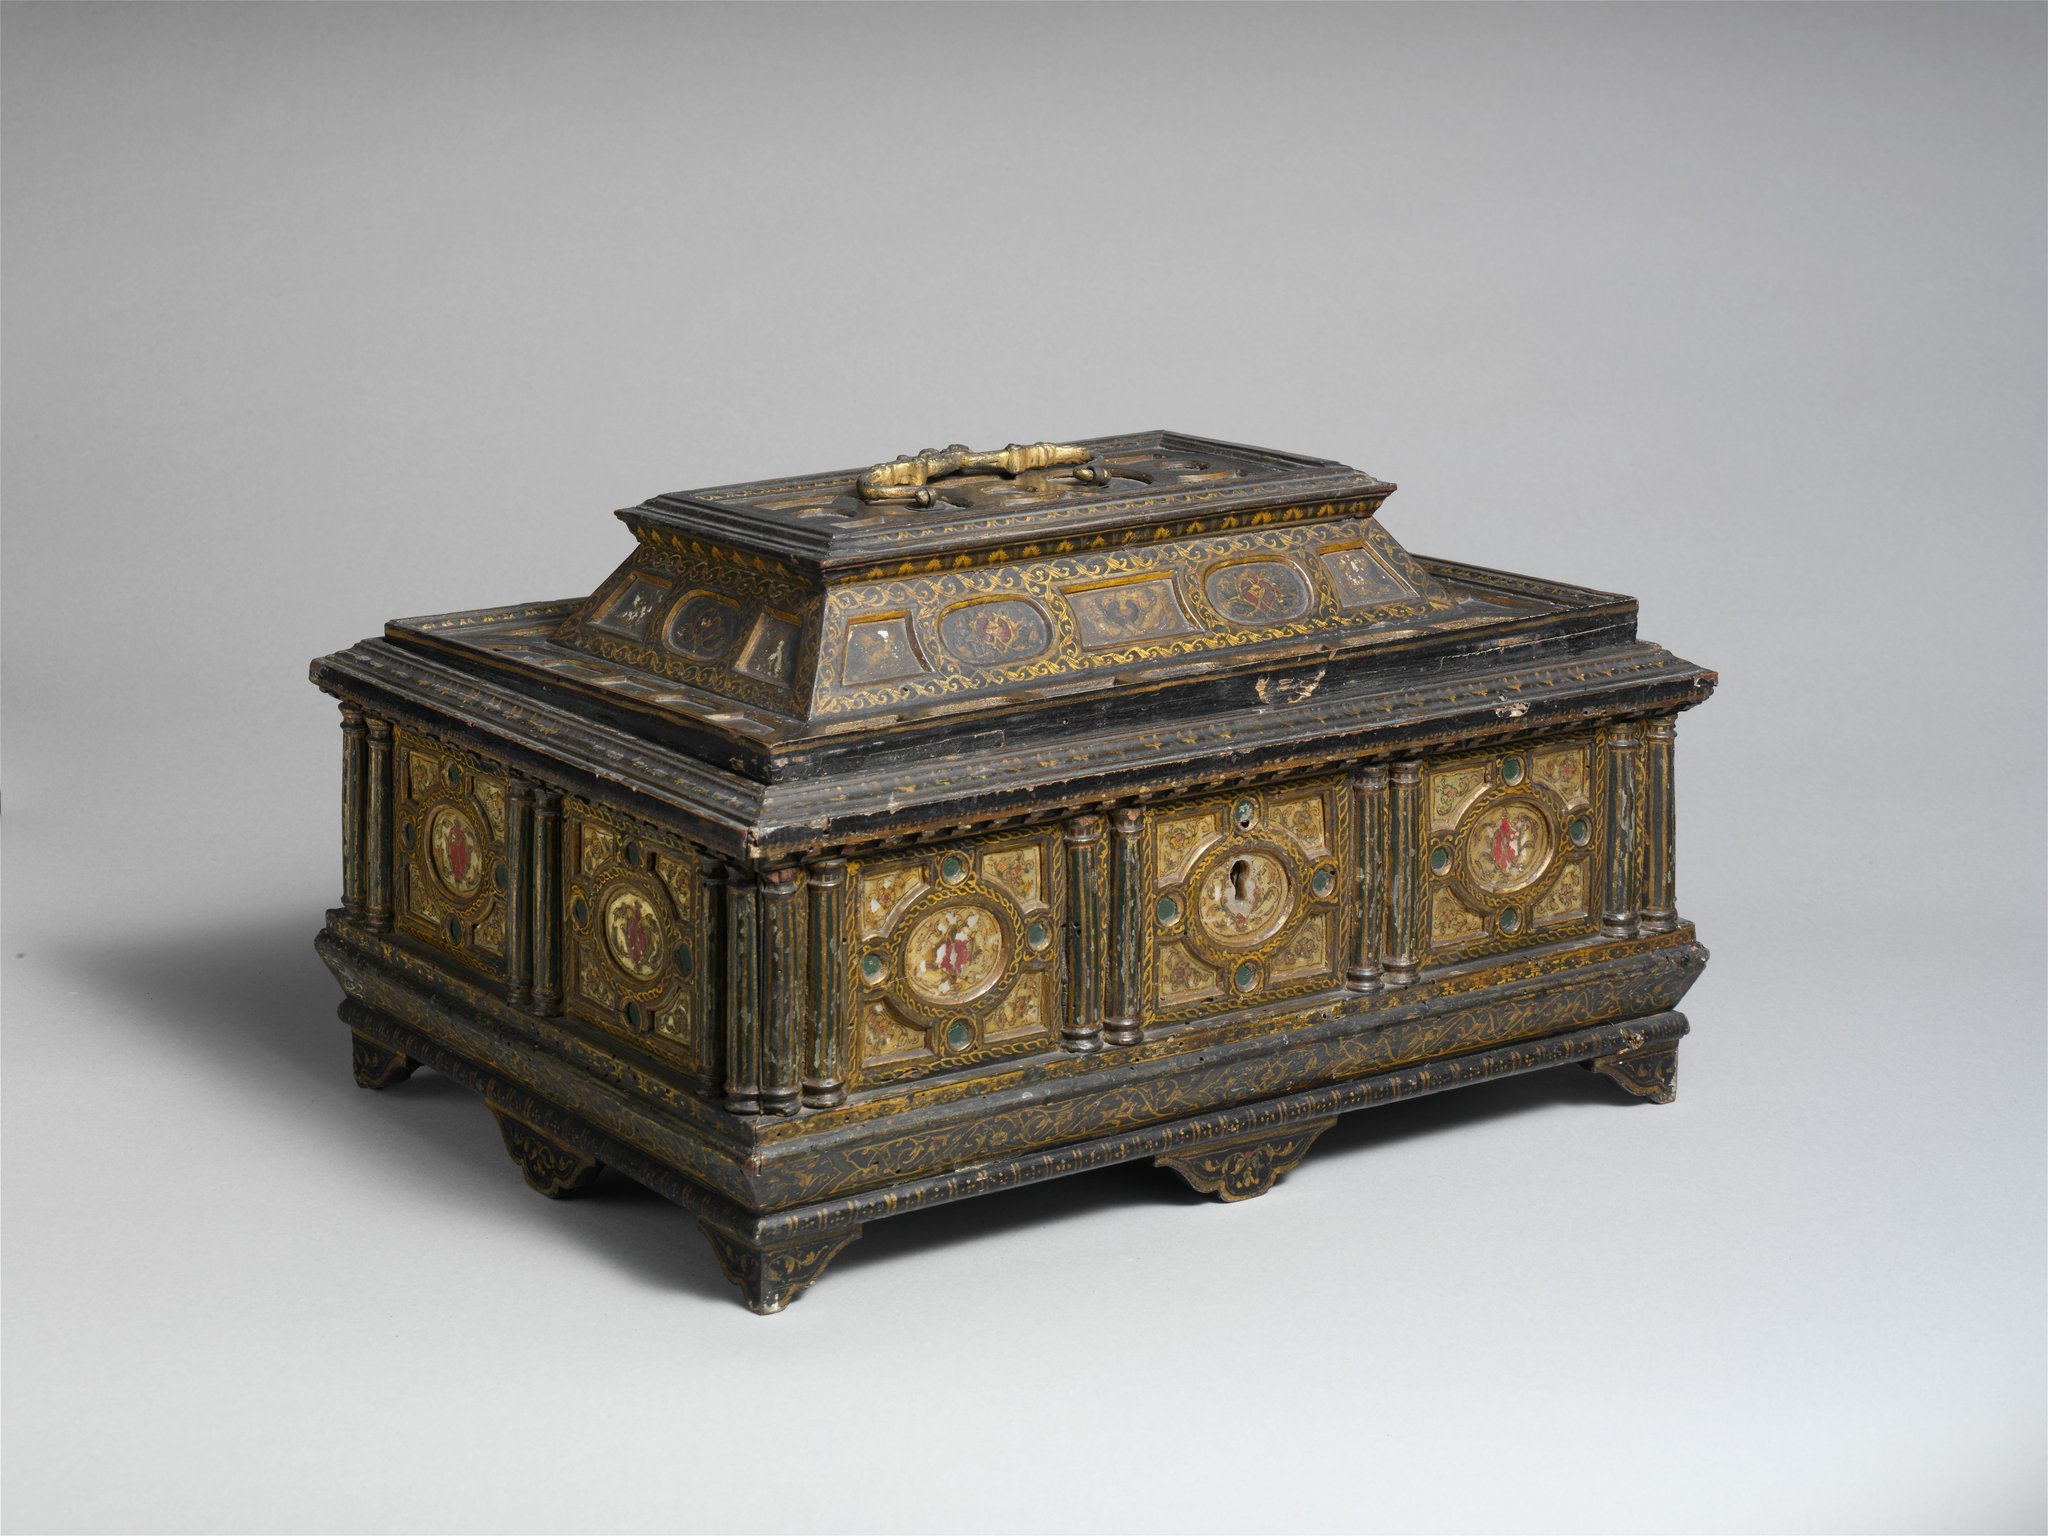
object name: casket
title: Casket (cassetta)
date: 1501-1600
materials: mother of pearl, wood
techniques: carving, gilding, inlay, painting